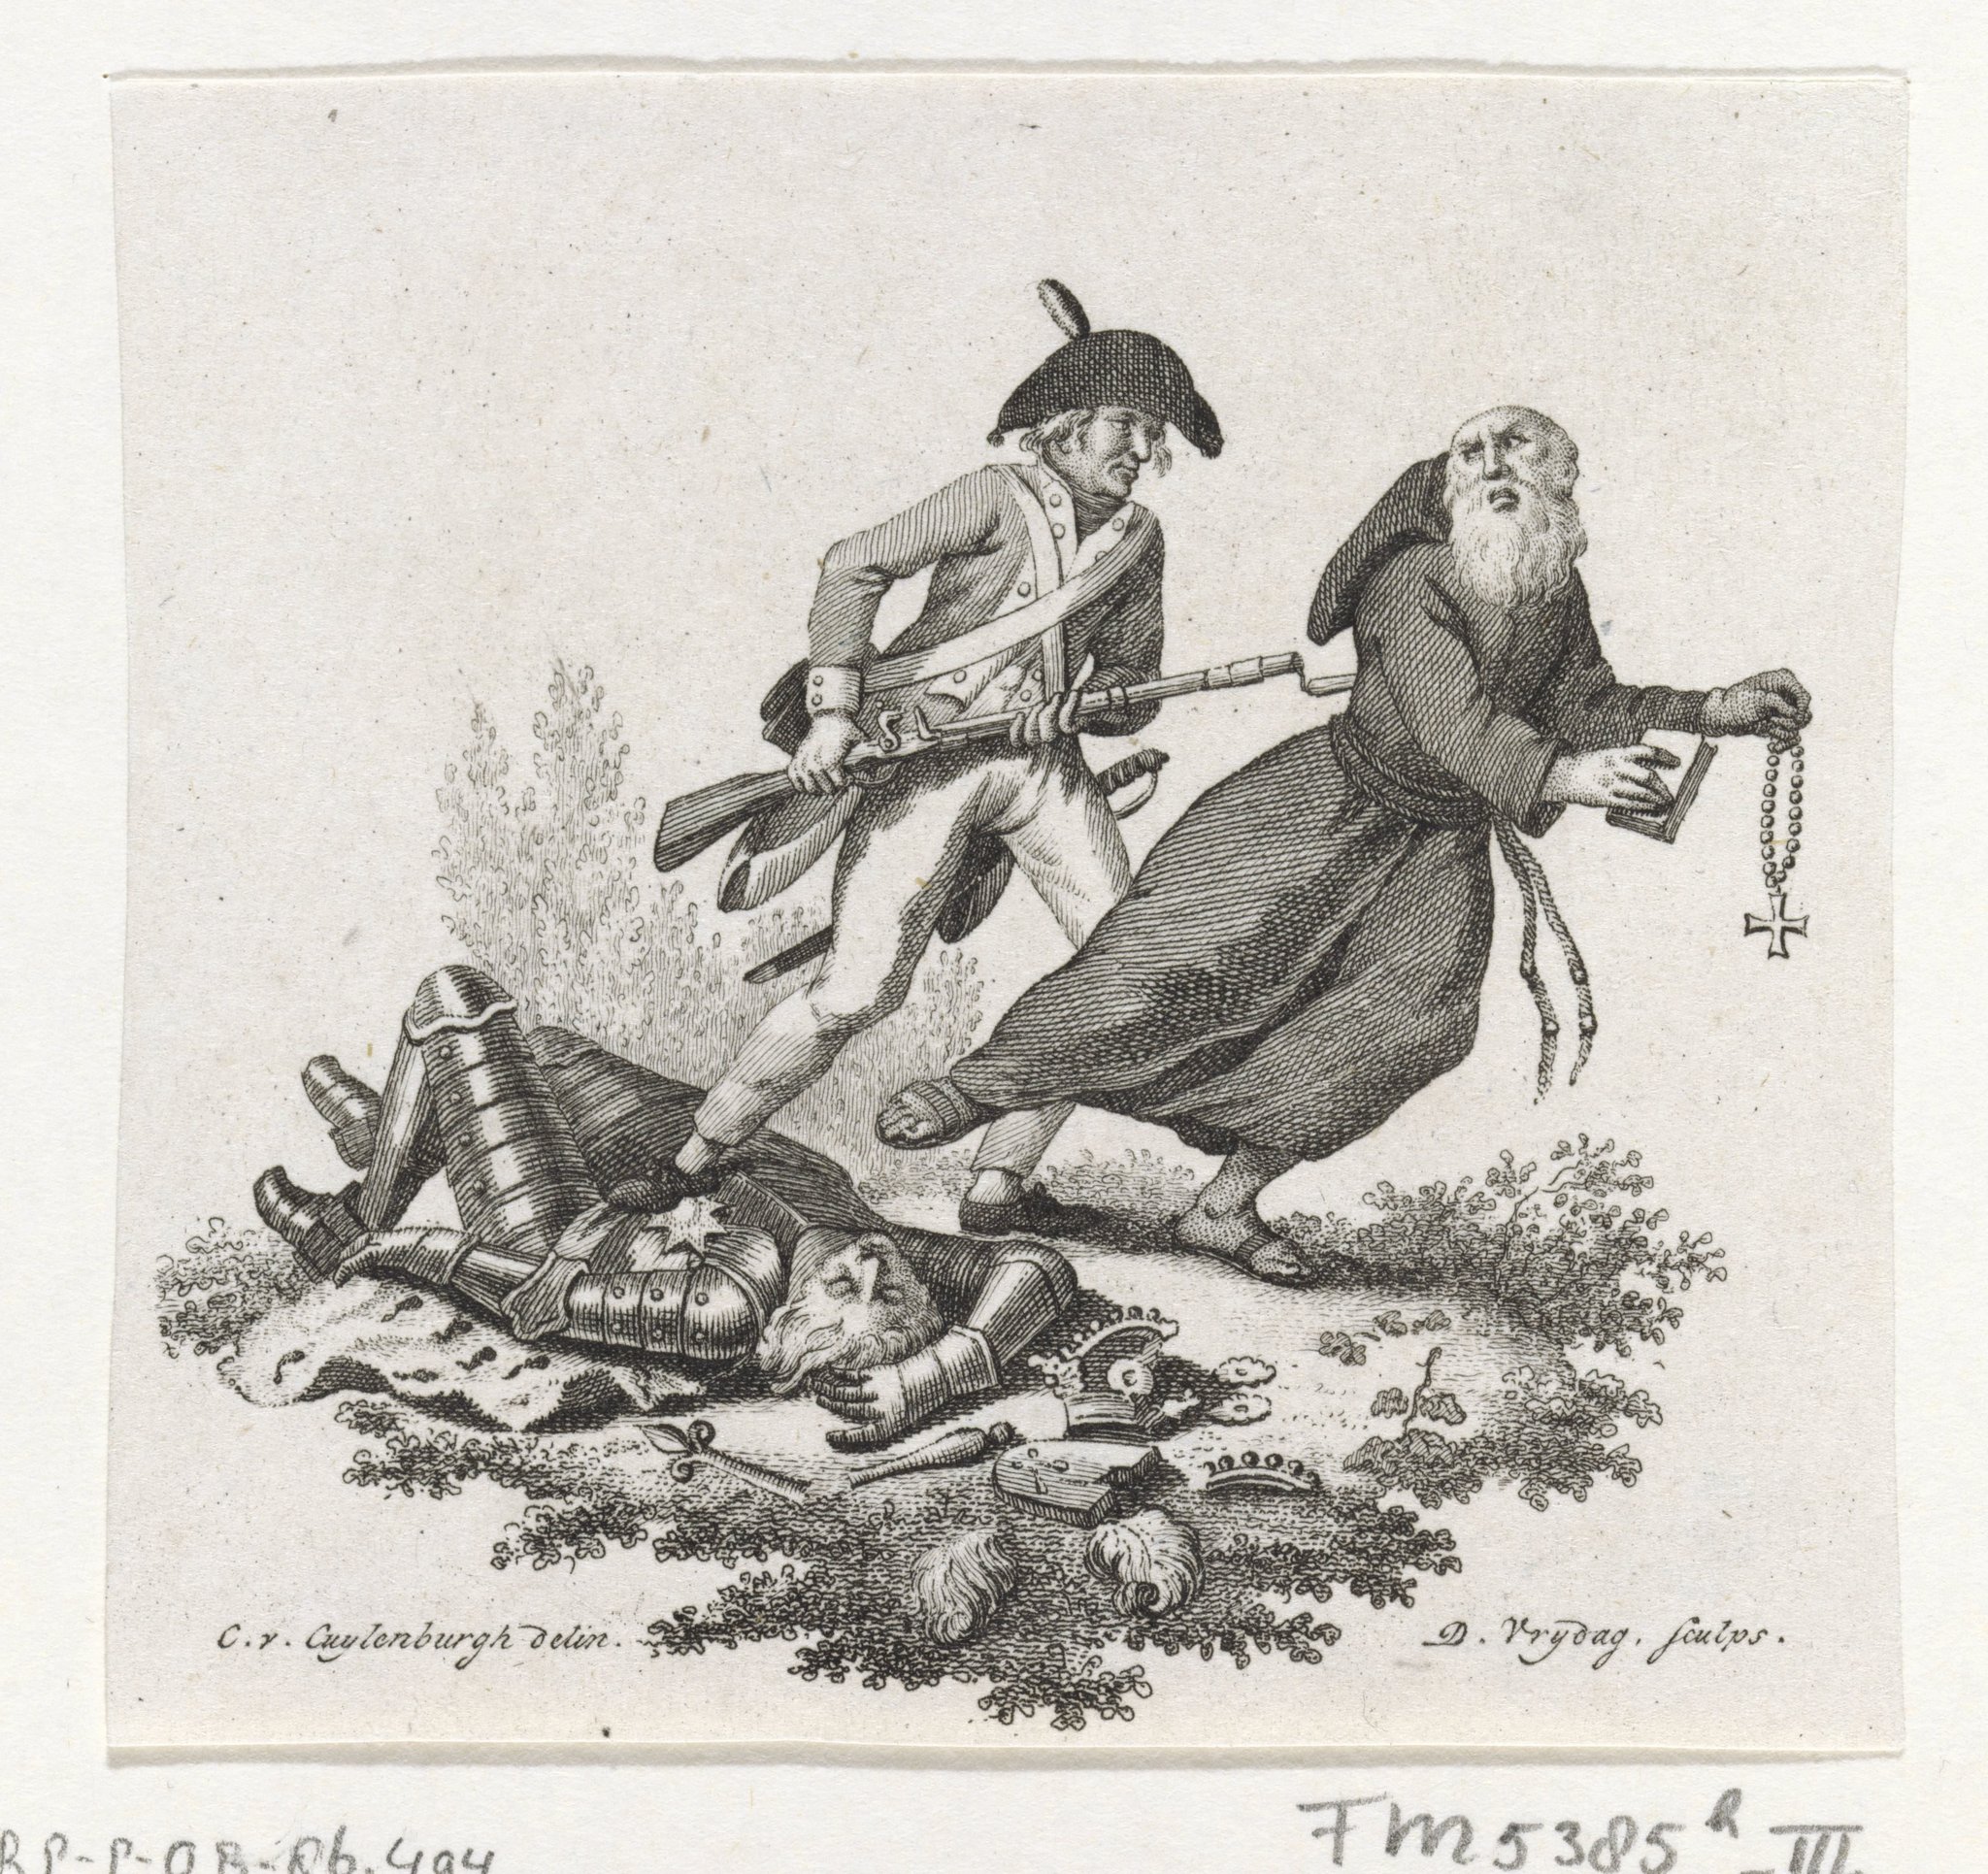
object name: print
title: Titelvignet, 1798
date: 1798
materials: paper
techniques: engraving, etching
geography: netherlands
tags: franse revolutie, bataafse revolutie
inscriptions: collector's mark: Lugt 2228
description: Gebruikt als illustratie in: C. Zillesen. Geschiedenis der Vereenigde Nederlanden, nevens de voornaamste gebeurtenissen in Europa, 6 dln, Den Haag: J.C. Leeuwestijn, dl. 2 (1798).